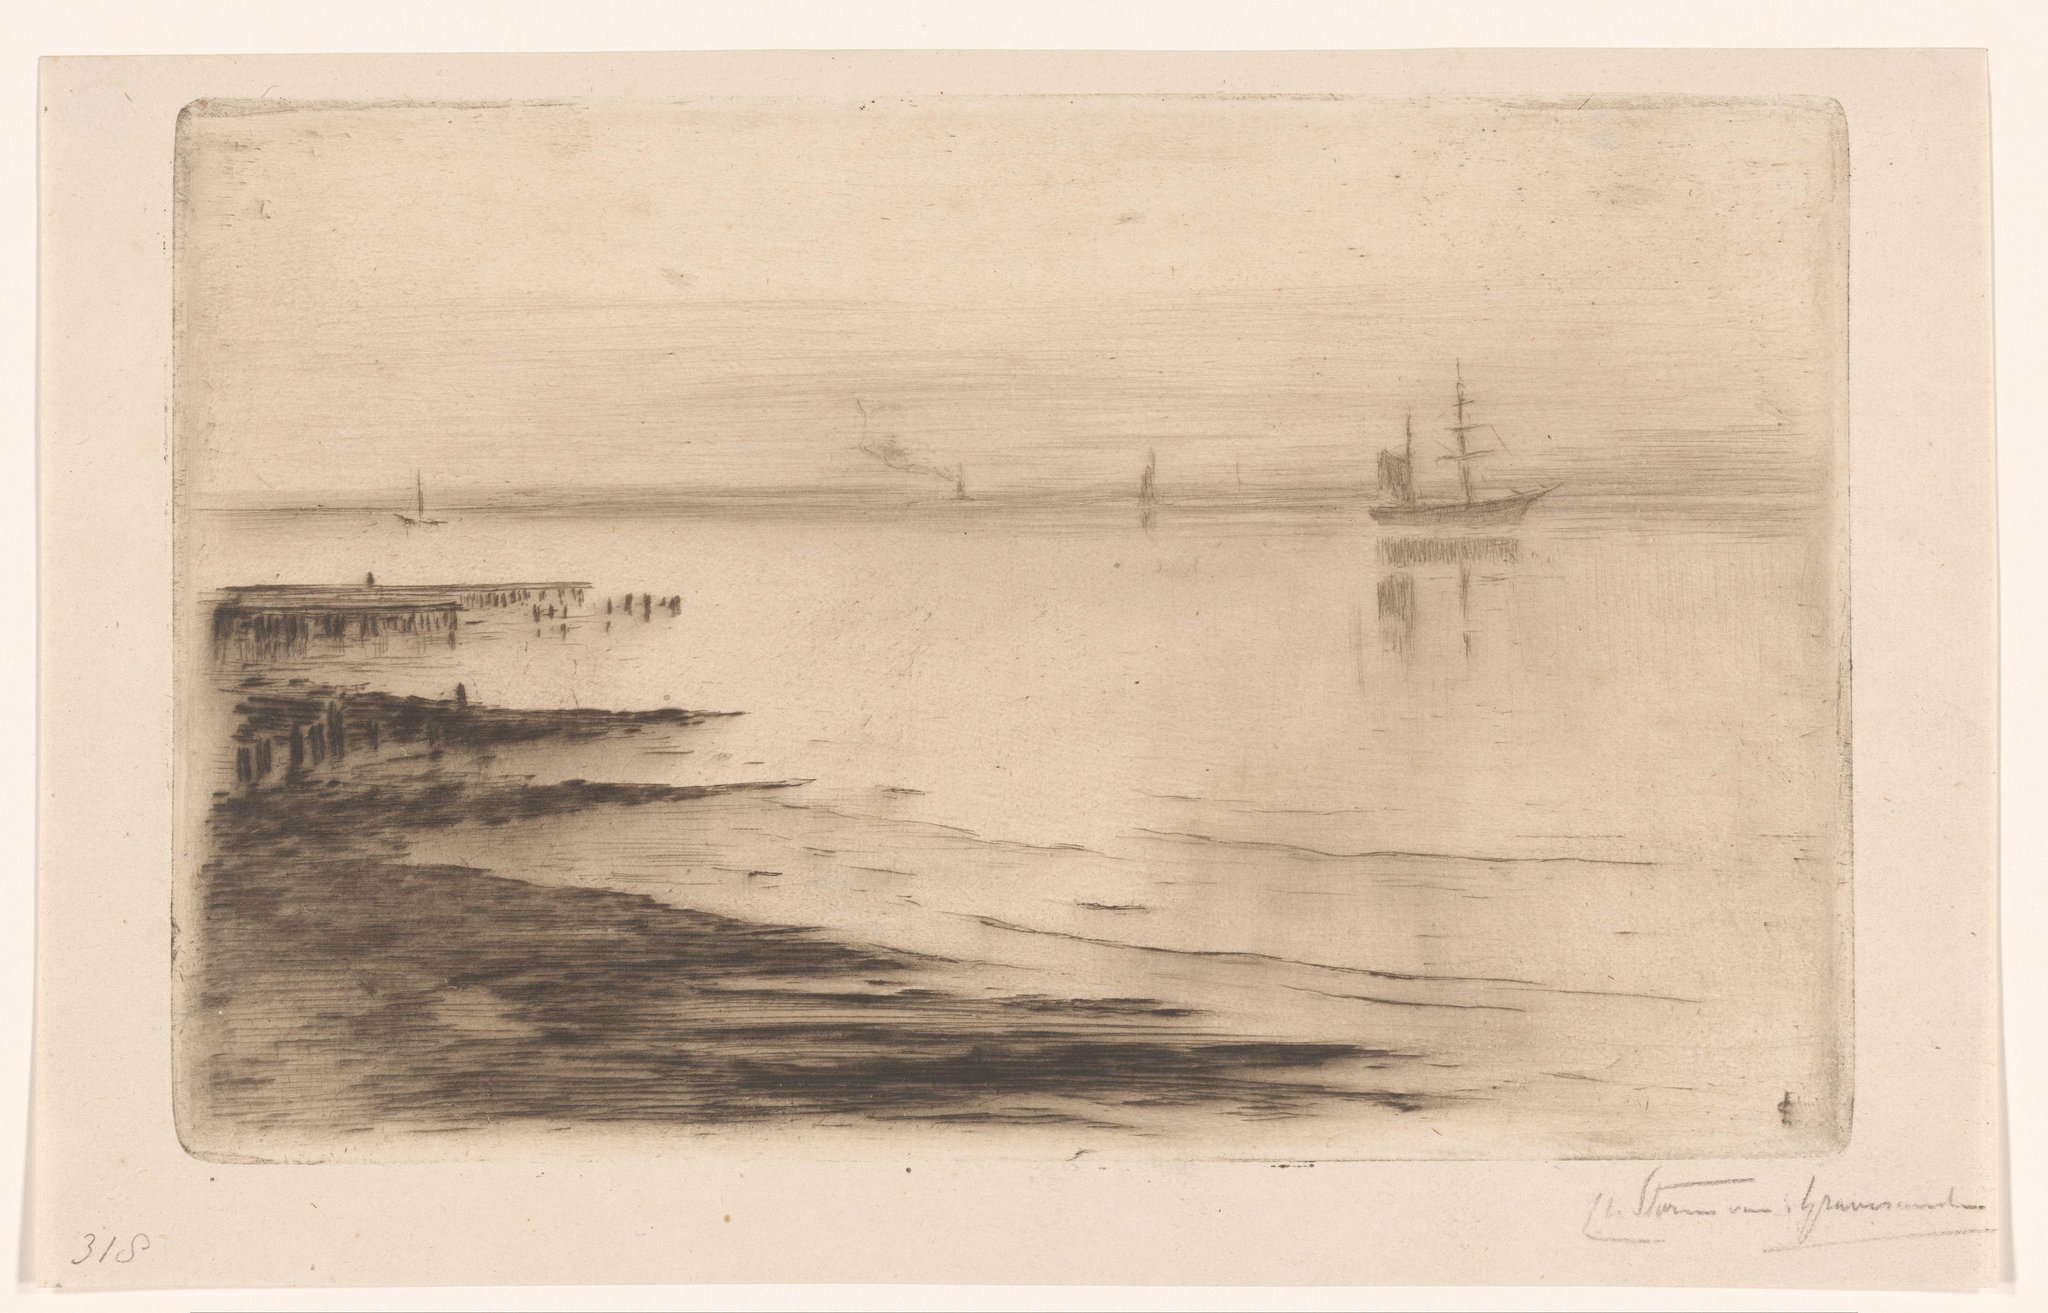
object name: print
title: Gezicht op de Schelde bij ochtend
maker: carel nicolaas storm van s-gravesande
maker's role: draughtsman, print maker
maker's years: 1841-1924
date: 1889-1902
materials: paper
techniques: drypoint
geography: netherlands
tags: river, morning, beach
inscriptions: collector's mark: Lugt 2228, number: ‘318’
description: Mogelijk vermeld in: Storm van 's-Gravesande, Charles. Catalogue des eaux-fortes et lithographies. New York: s.n., 1903, of in een onbekende latere uitgave van het manuscript. Vermoedelijk vermeld als catalogusnummer 318.